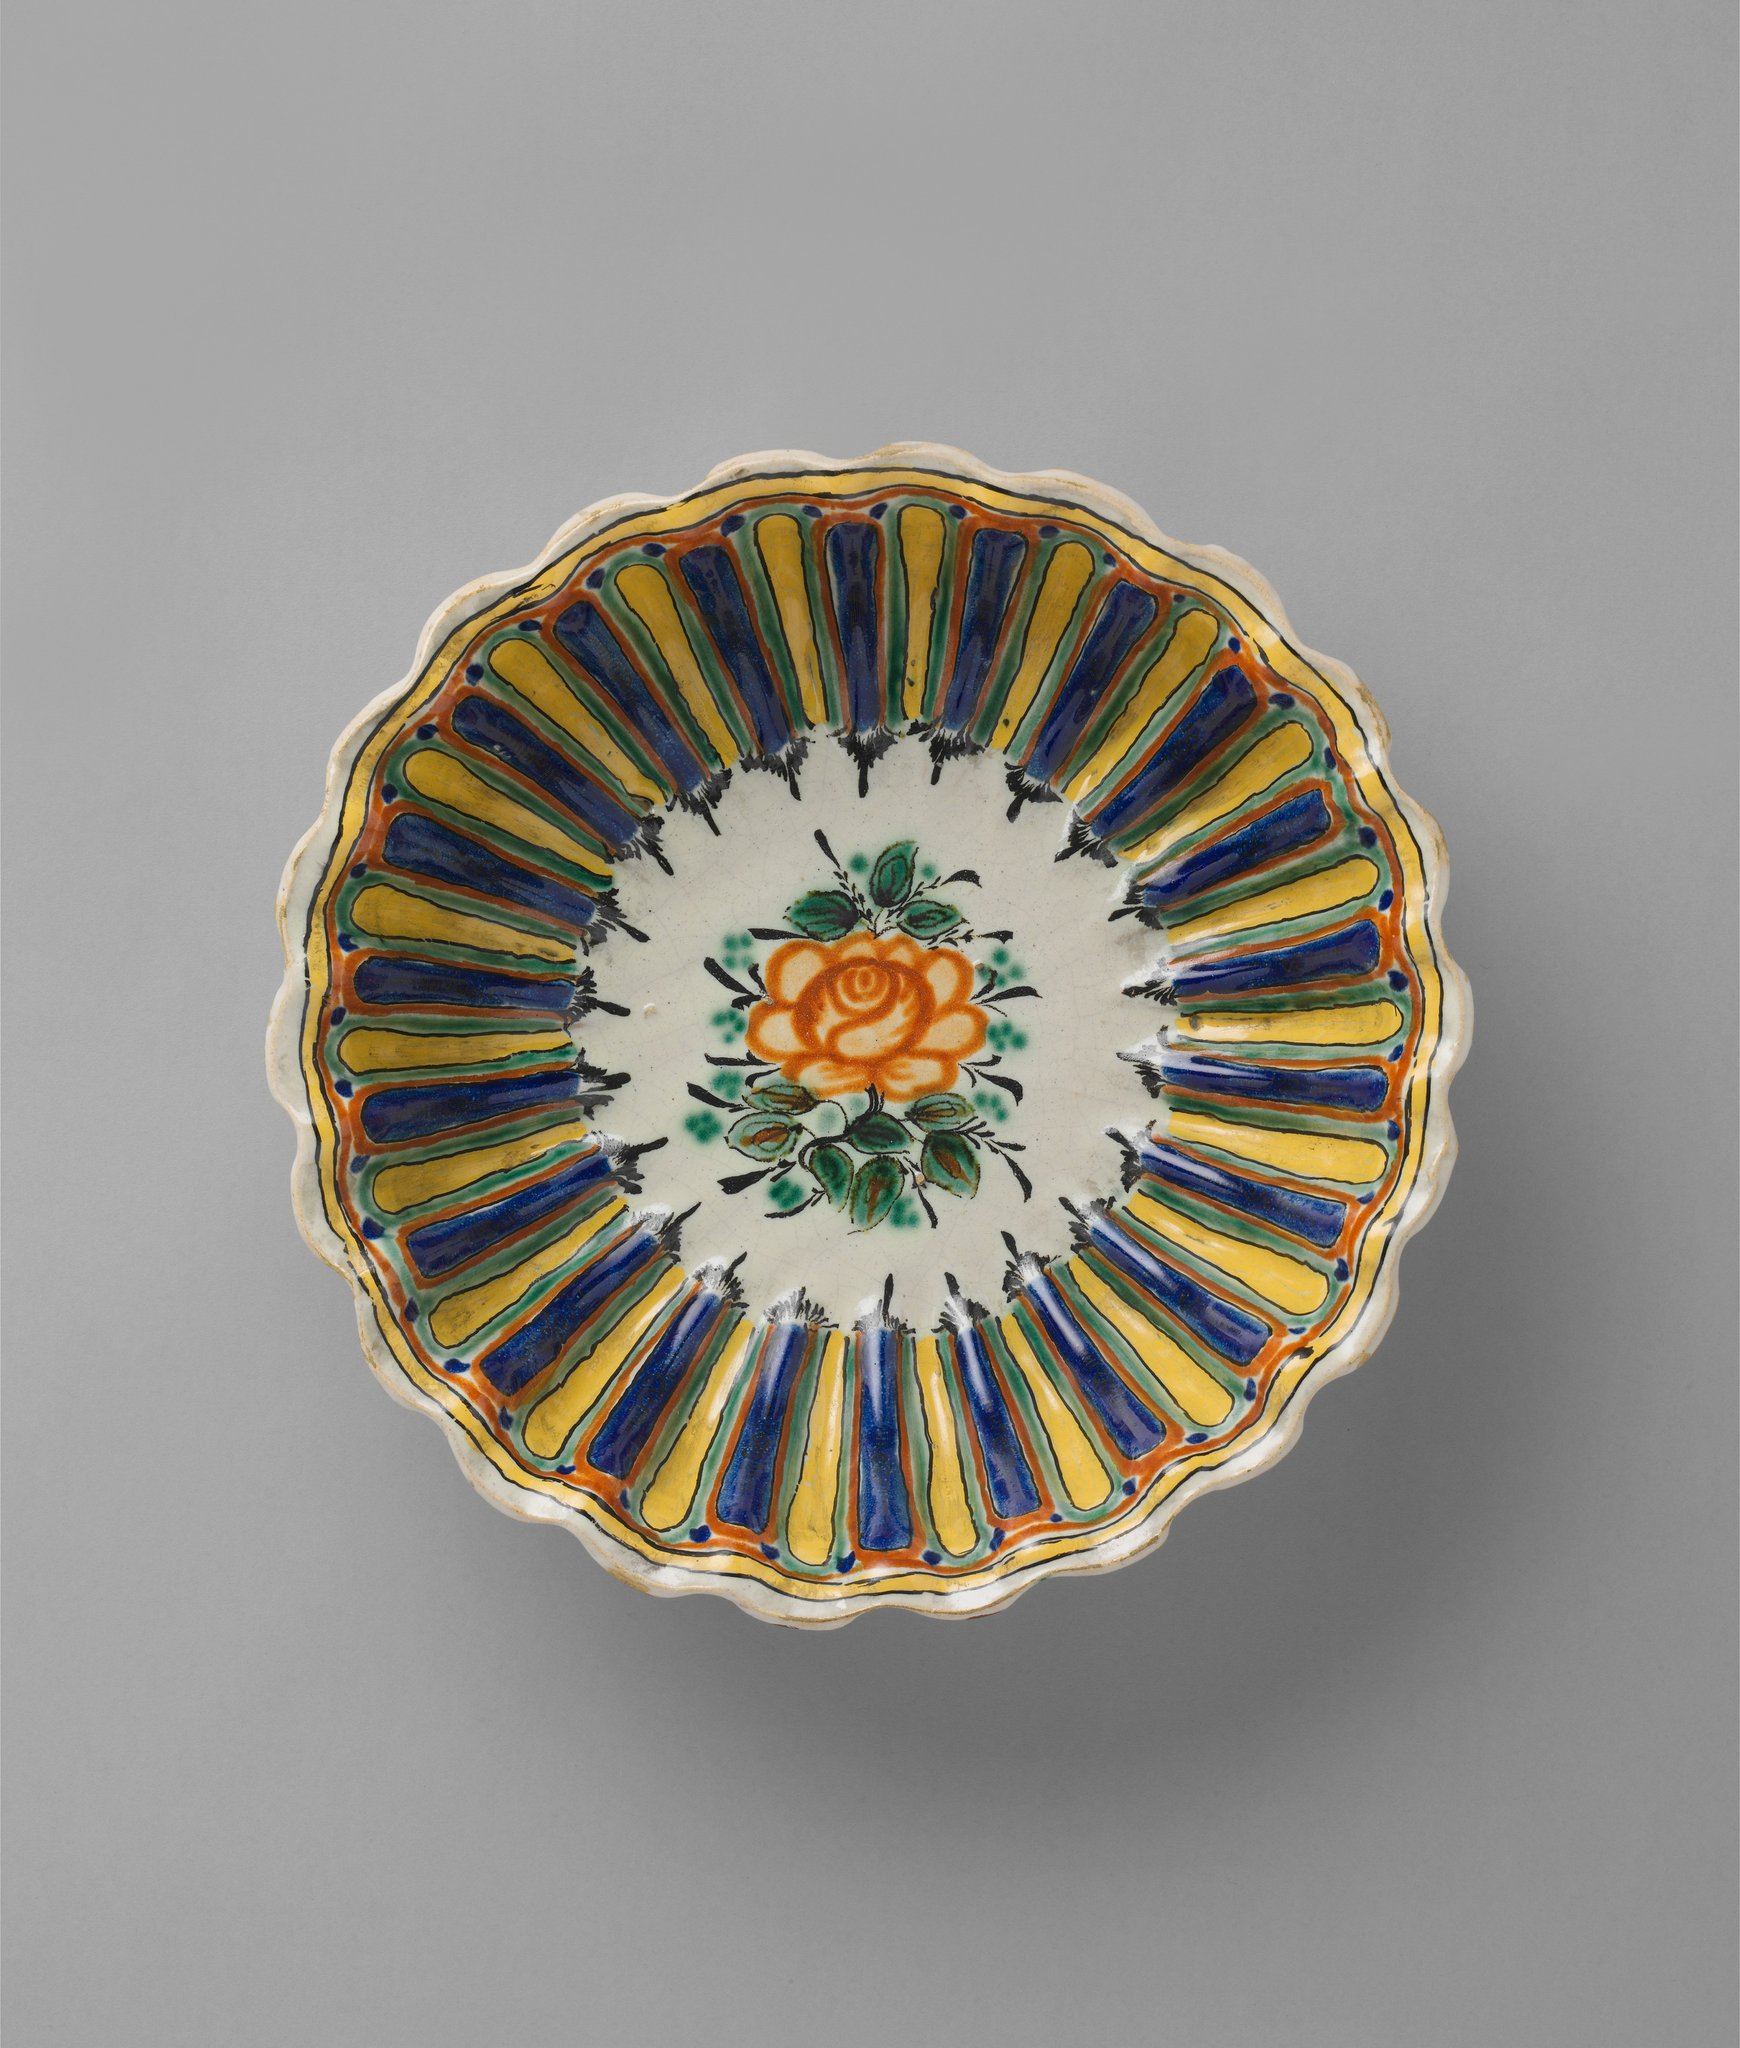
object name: bowl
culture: mexican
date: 1875-1900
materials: earthenware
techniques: glazing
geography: mexico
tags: flowers